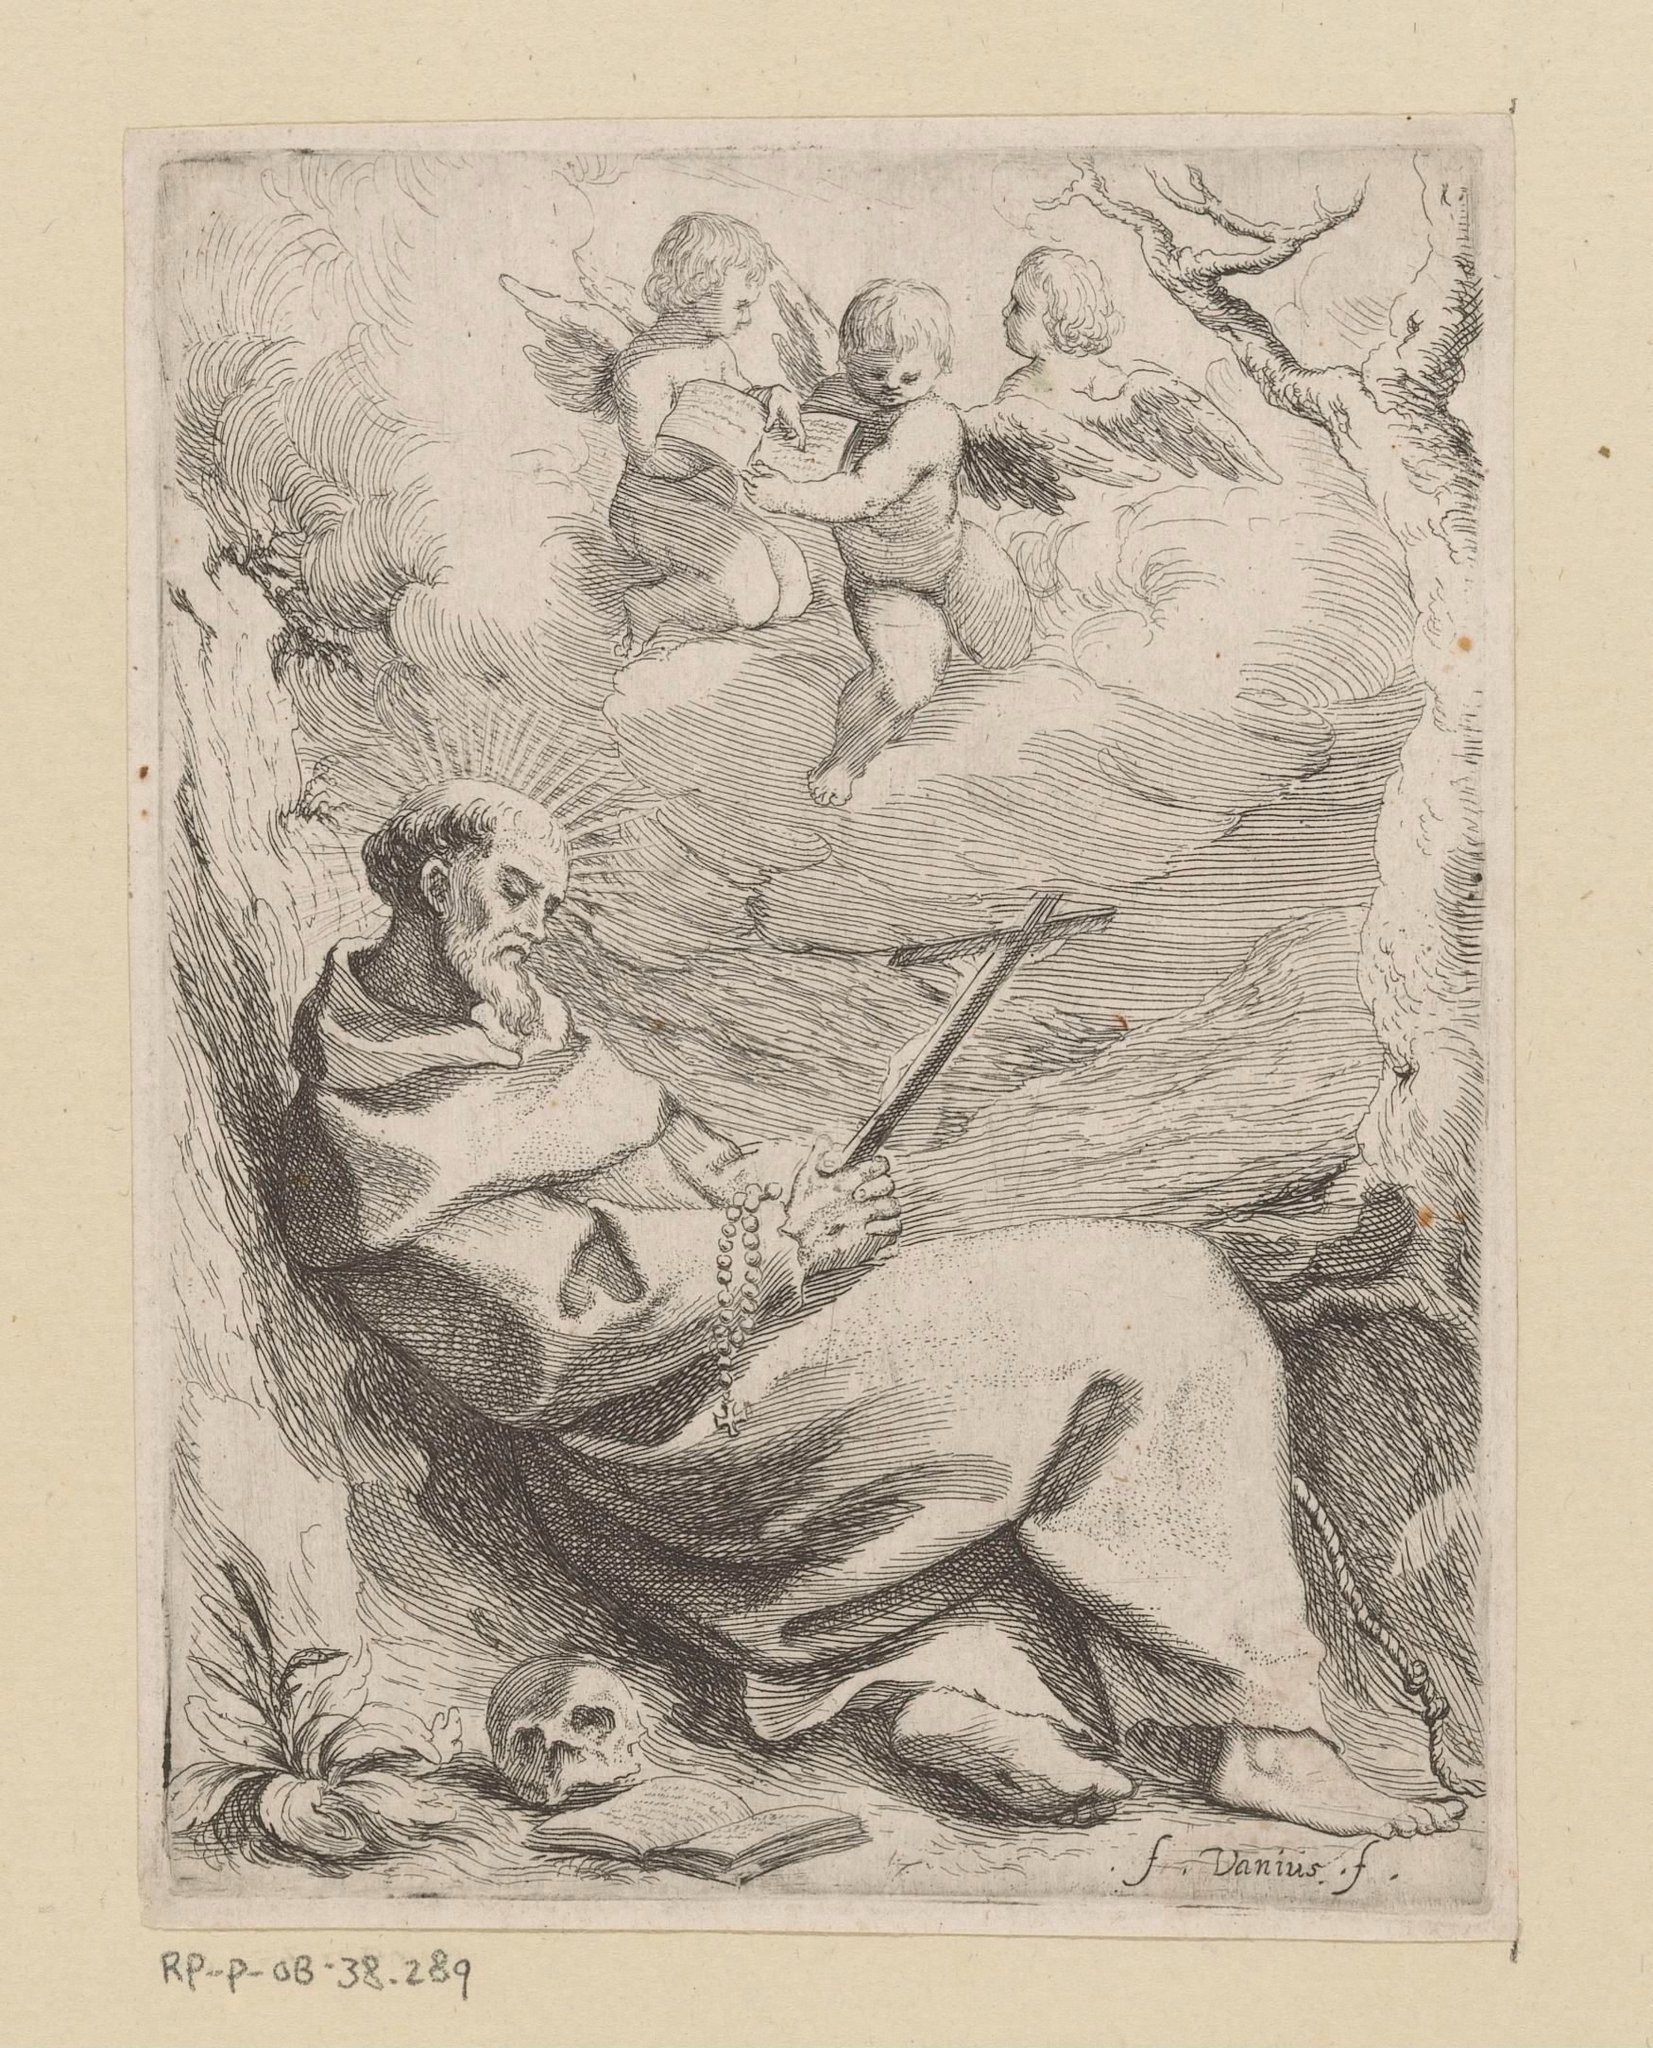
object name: print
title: Heilige Franciscus van Assisi met crucifix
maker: willem basse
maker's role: draughtsman, print maker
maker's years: 1613-1672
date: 1523-1672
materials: paper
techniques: etching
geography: netherlands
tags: founder of the order of friars minor (franciscans), francis(cus) of assisi; possible attributes: book, crucifix, lily, skull, stigmata, angels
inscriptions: collector's mark: Lugt 240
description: De heilige Franciscus, liggend met een crucifix in de handen. Op de voorgrond een boek en doodskop. Boven drie engelen met een boek.